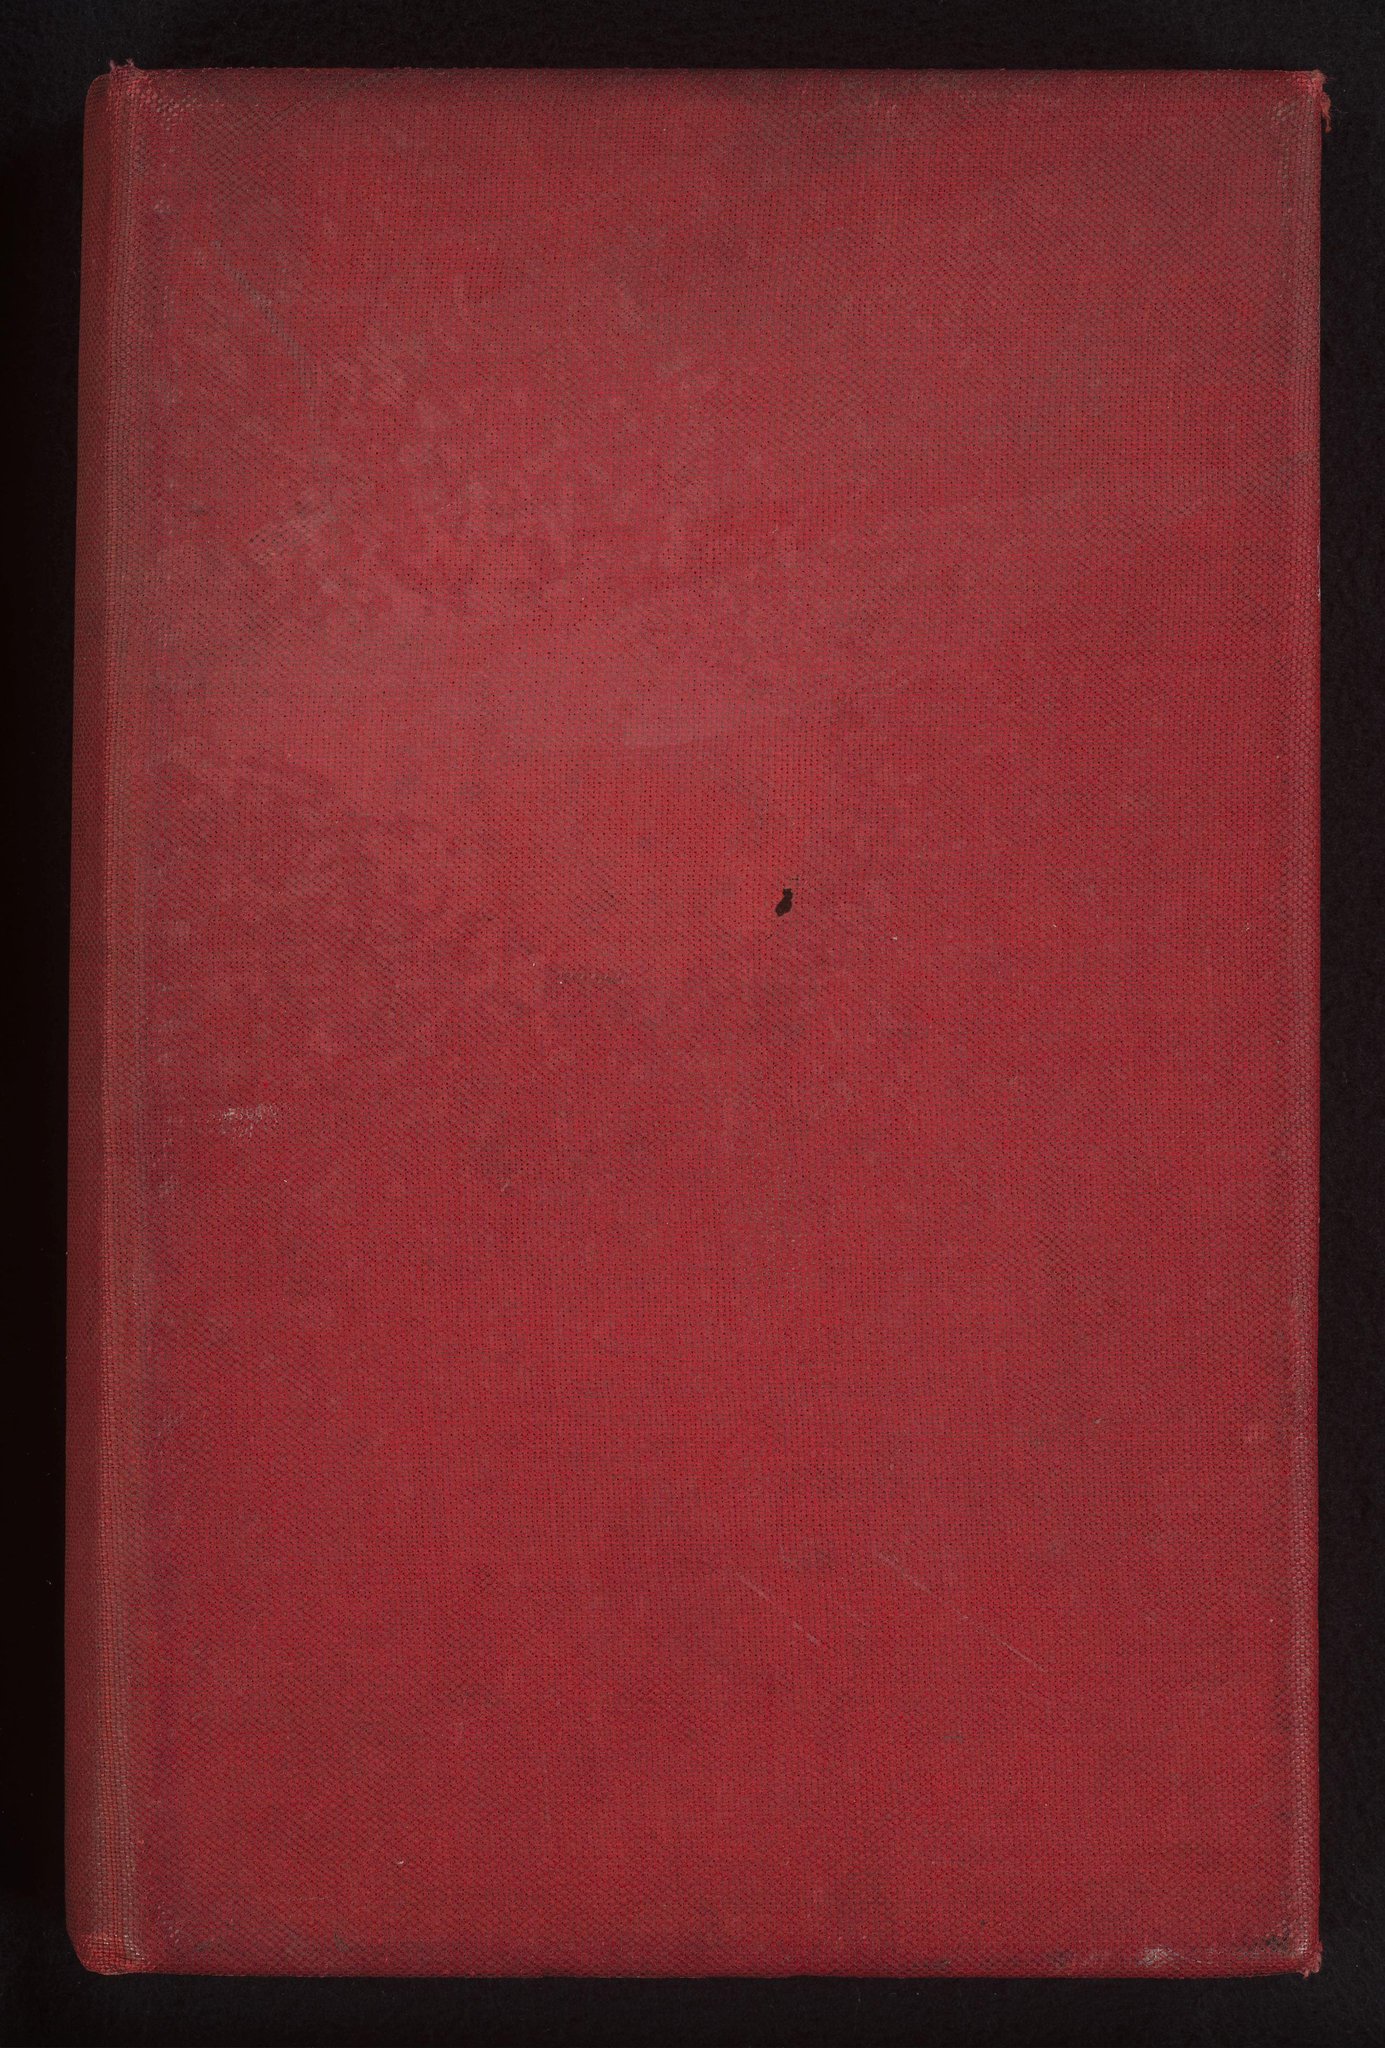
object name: photograph album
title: Fotoalbum met foto's van Volendam, Dordrecht en mogelijk andere dorpen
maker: george hidderley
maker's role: fotograaf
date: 1900-1920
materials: cardboard, linen, paper, photographic support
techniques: gelatin silver print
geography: great britain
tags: sailing-ship, sailing-boat, historical persons, folk costume, regional costume, street, dordrecht, woudrichem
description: Fotoalbum met 24 pagina's met in totaal 45 foto's. Op iedere pagina zijn twee passe-partouts, niet alle passe-partouts zijn gevuld. De opnames zijn waarschijnlijk gemaakt door de Engelse fotograaf G. Hidderley tijdens een reis met vrienden of familie door Nederland. Dit resulteerde in een serie van vijf fotoalbums. Daarnaast behoren nog 13 losse foto's tot deze reeks. Het onderhavige album bevat foto's die vermoedelijk zijn gemaakt in Volendam en Dordrecht, en mogelijk andere steden en dorpen in Nederland.